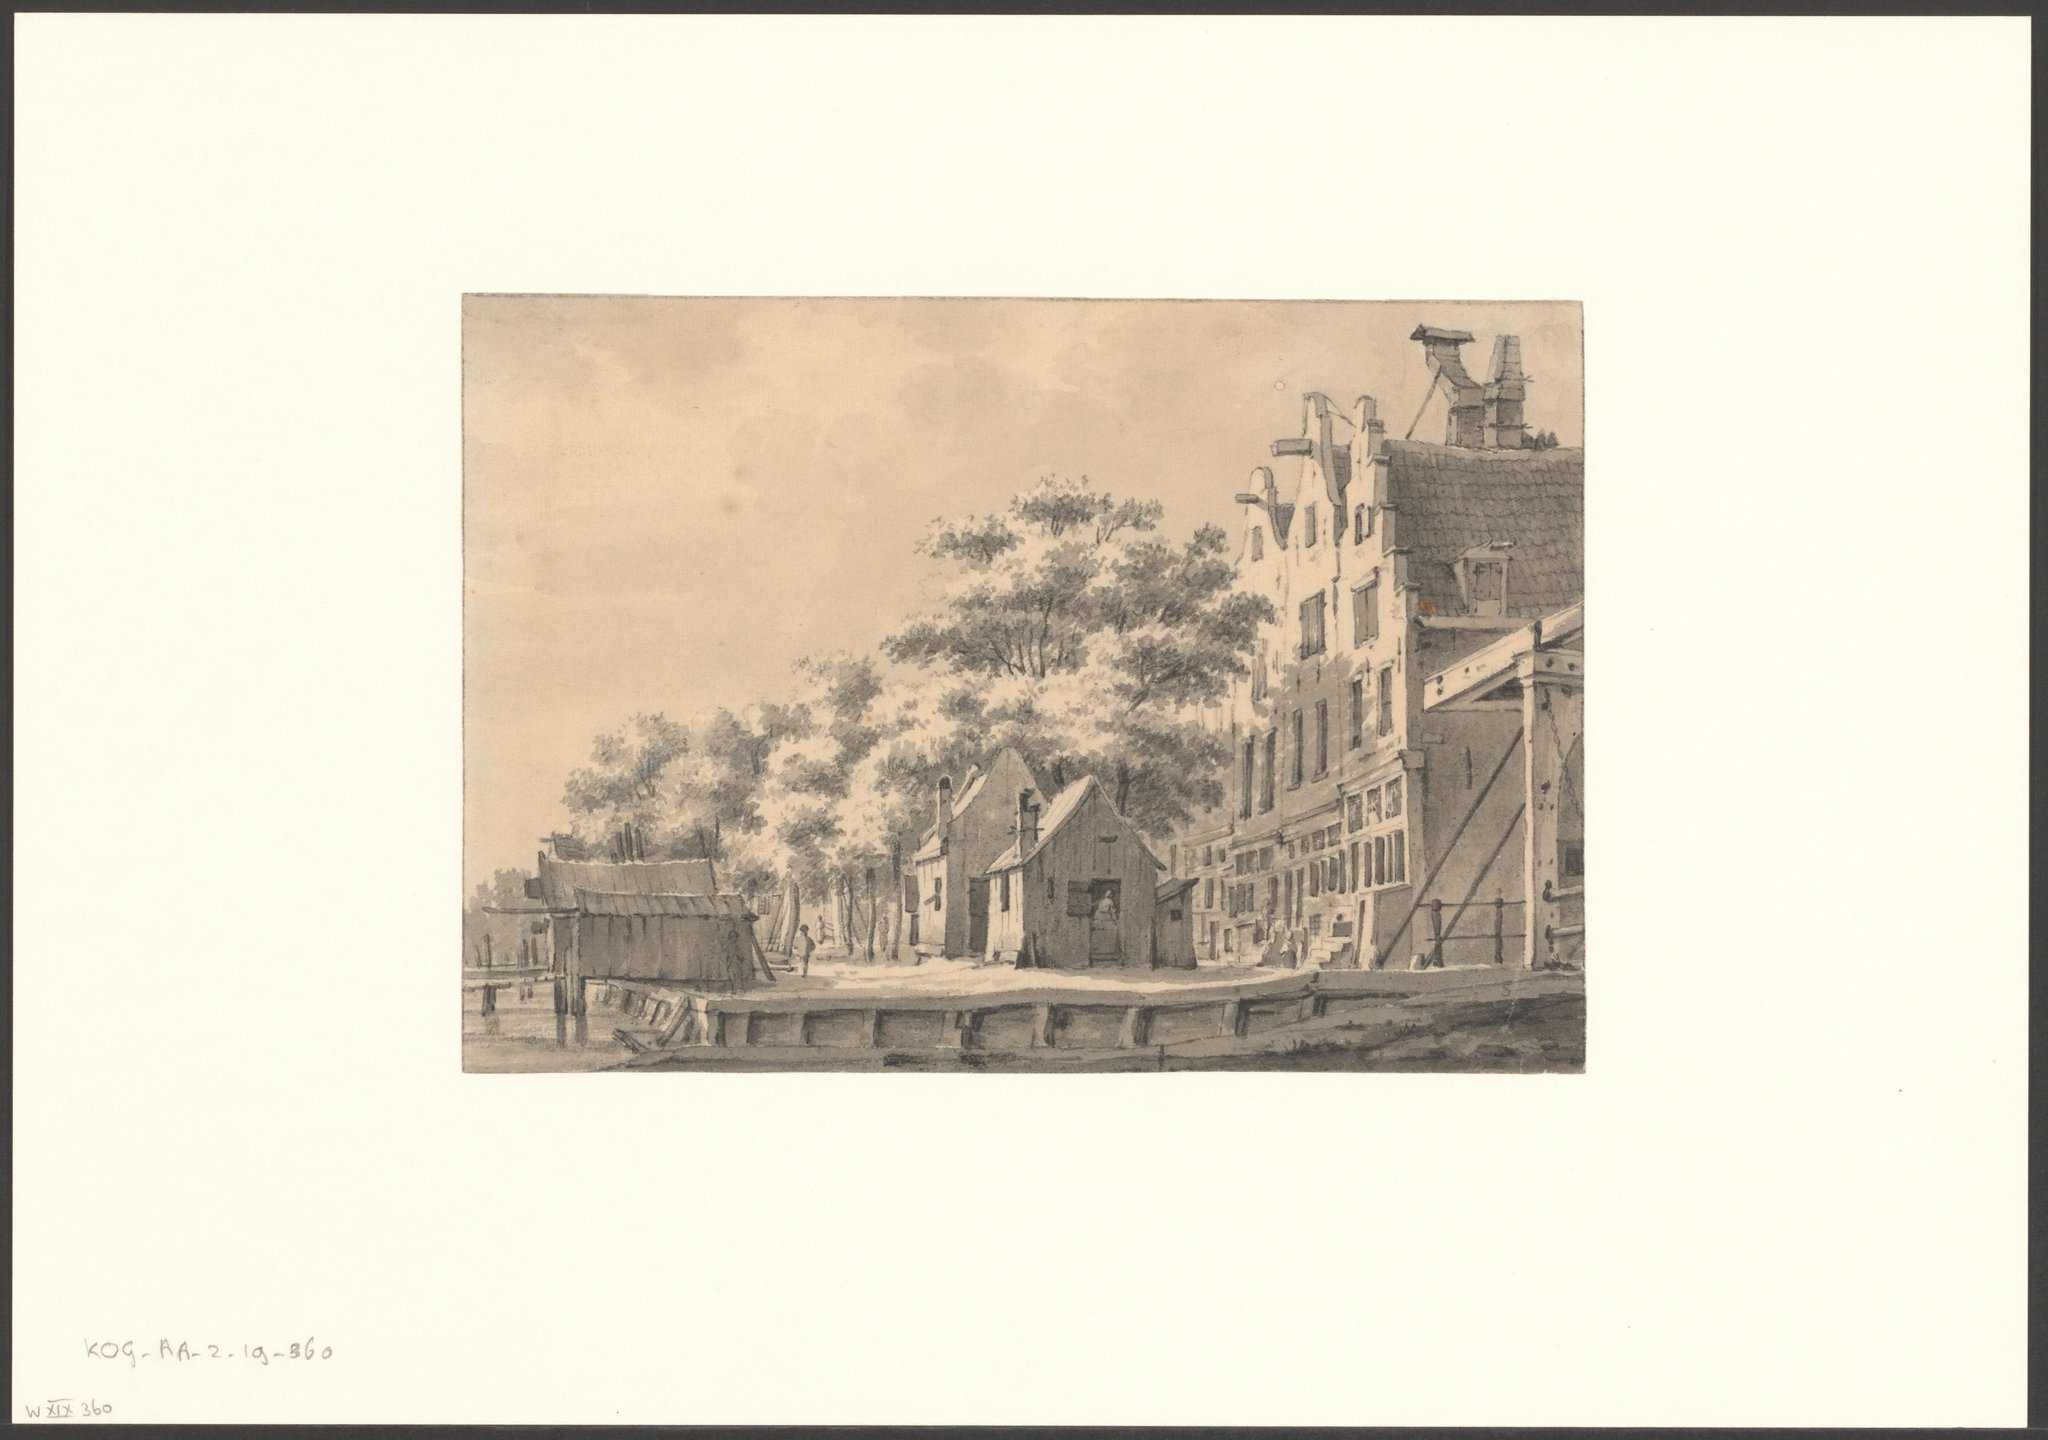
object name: drawing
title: Gezicht op de Zandhoek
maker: gerrit hulseboom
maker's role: draughtsman, print maker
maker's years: 1784-1863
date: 1794-1863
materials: ink, paper, pencil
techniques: brush, pen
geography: amsterdam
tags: city-view in general; 'veduta', quay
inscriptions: collector's mark: Lugt 800a, signature: ‘JHülseboom’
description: Tekening binnen de Atlas Van Eck ingedeeld op wijknummer 19.